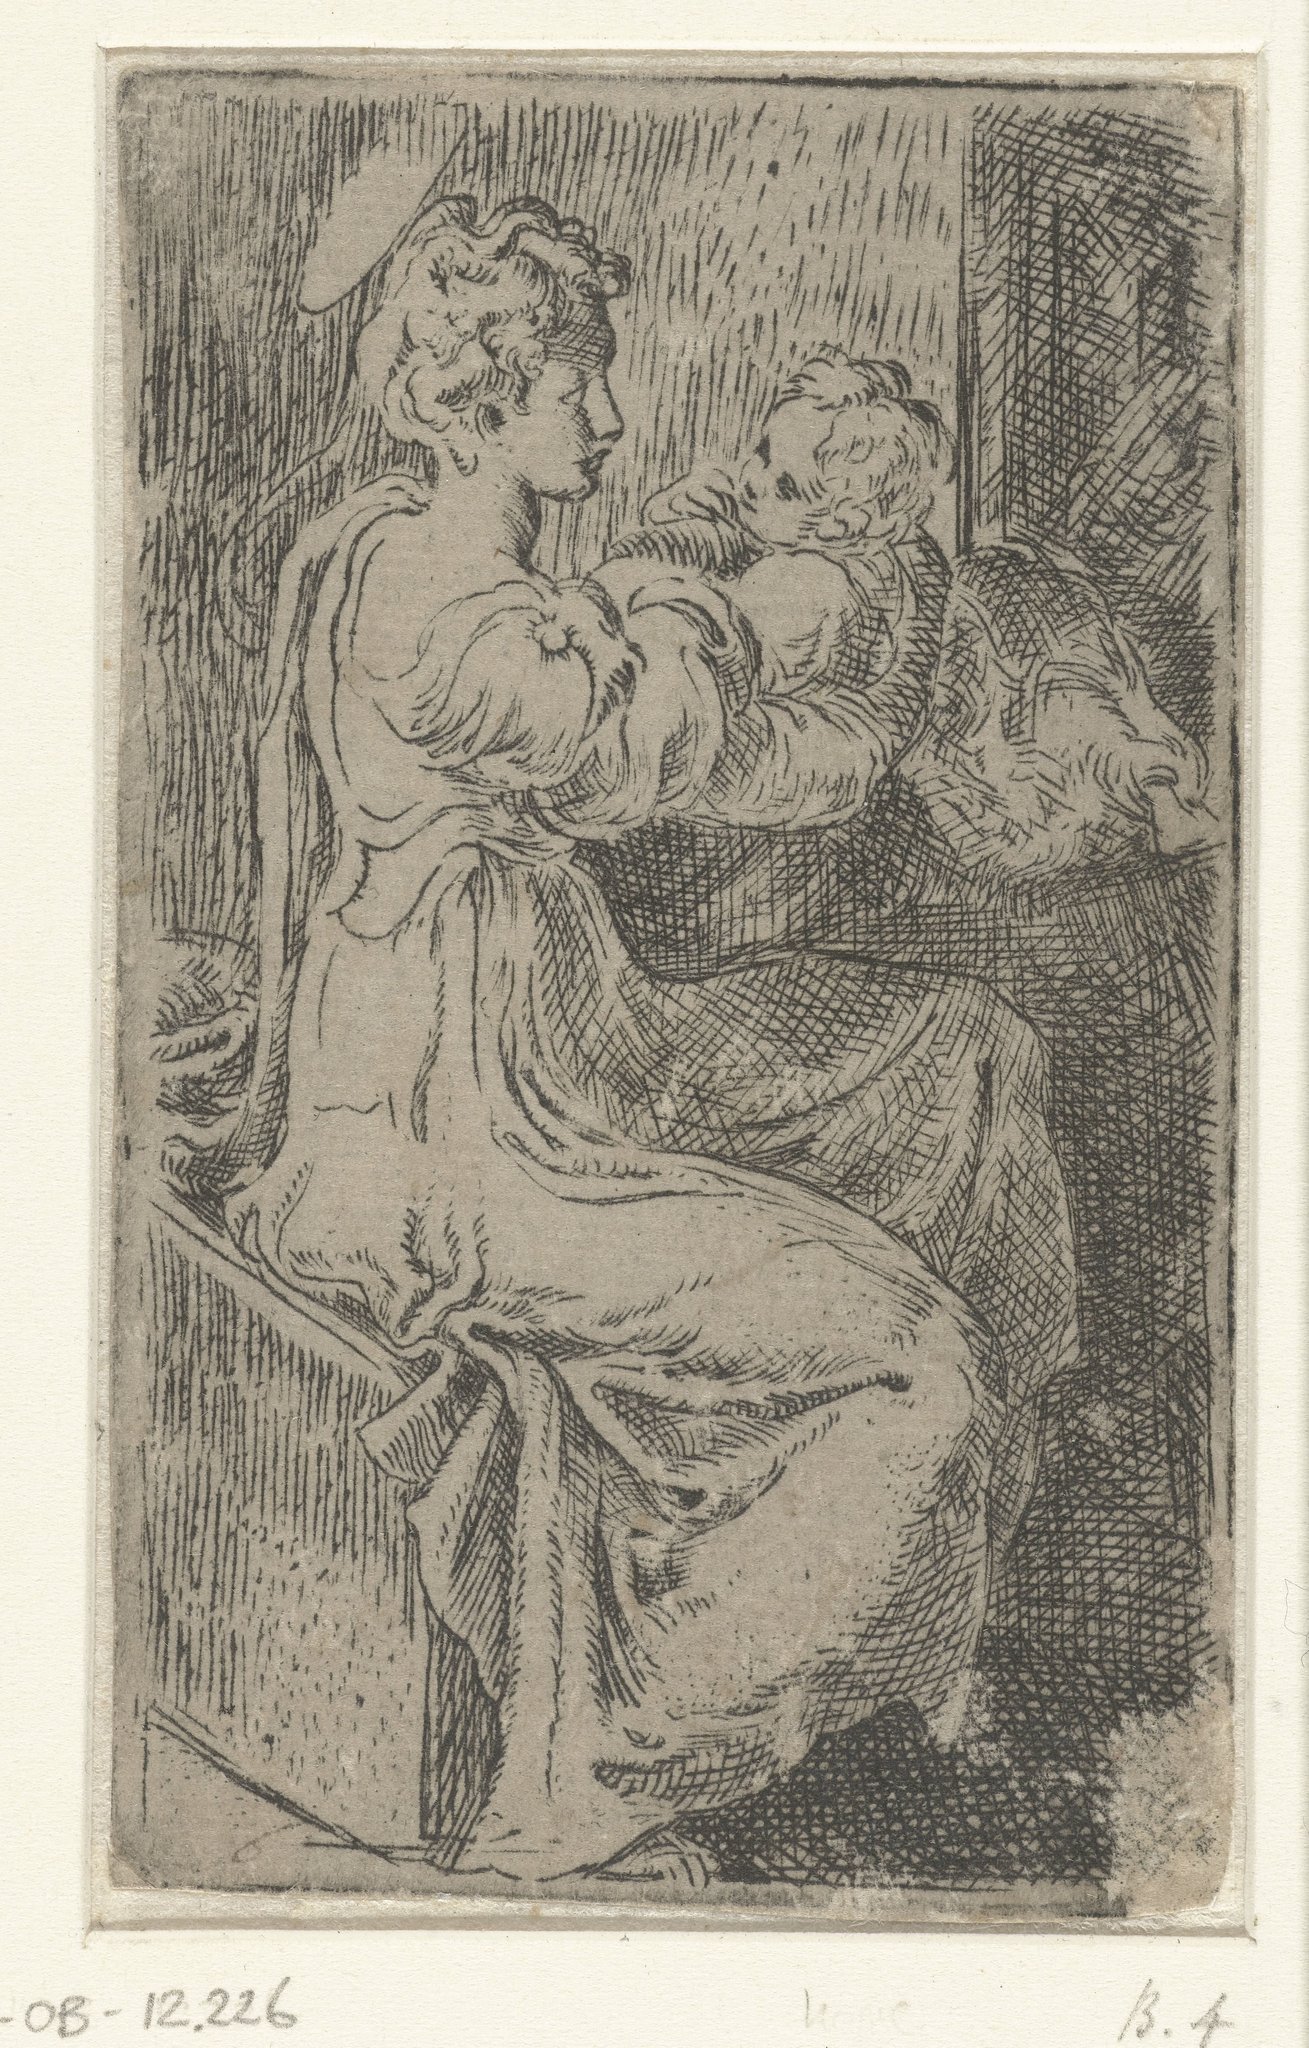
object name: print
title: Maria met kind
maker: parmigianino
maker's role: draughtsman, painter, print maker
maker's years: 1503-1540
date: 1524-1540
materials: paper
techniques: etching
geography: rome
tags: madonna: i.e. mary with the christ-child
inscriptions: collector's mark: Lugt 240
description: Maria met het Christuskind in haar armen.